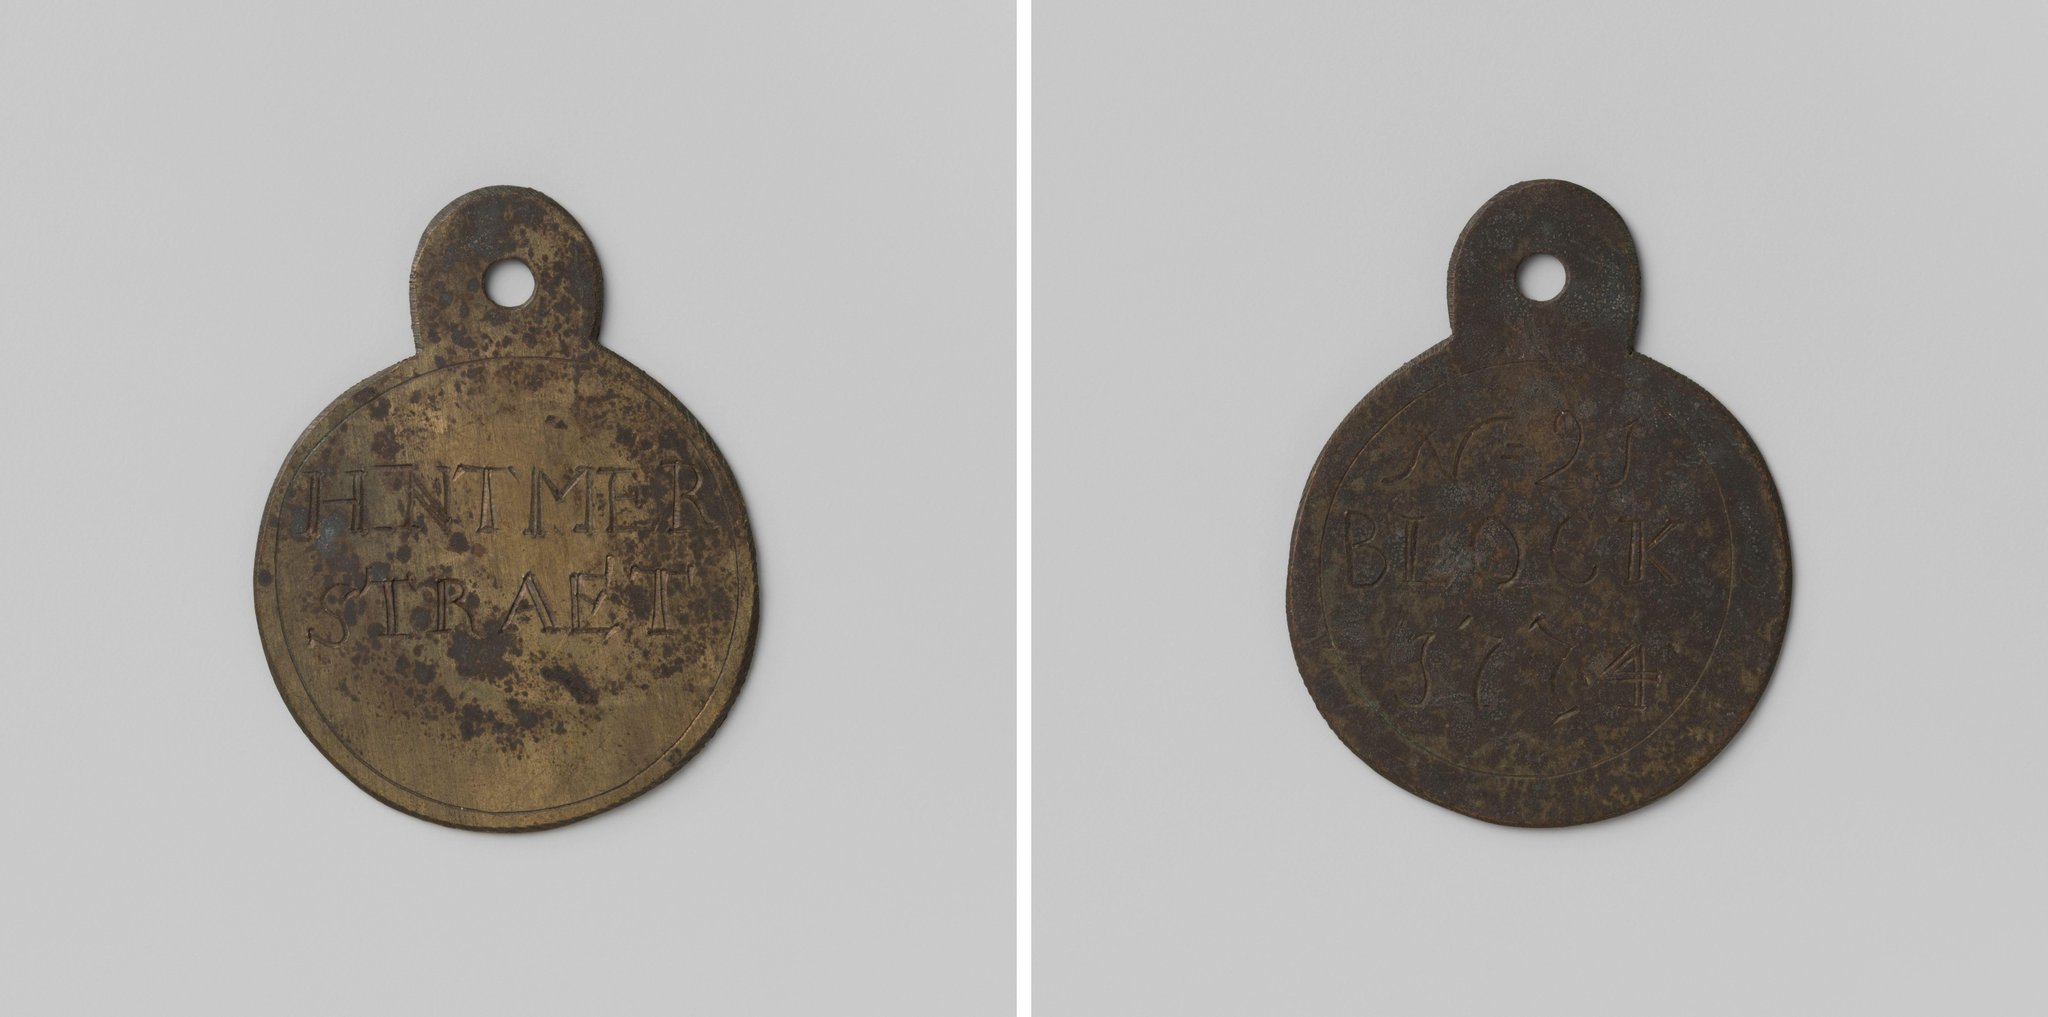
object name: identification medal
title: Armenpenning van het blok Hinthammerstraat te 's-Hertogenbosch, penning met no. 21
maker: Anonymous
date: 1774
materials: brass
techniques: engraving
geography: den bosch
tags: hinthammerstraat (den bosch)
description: Messing ovale penning aan draagoog. Voorzijde: opschrift. Keerzijde: opschrift